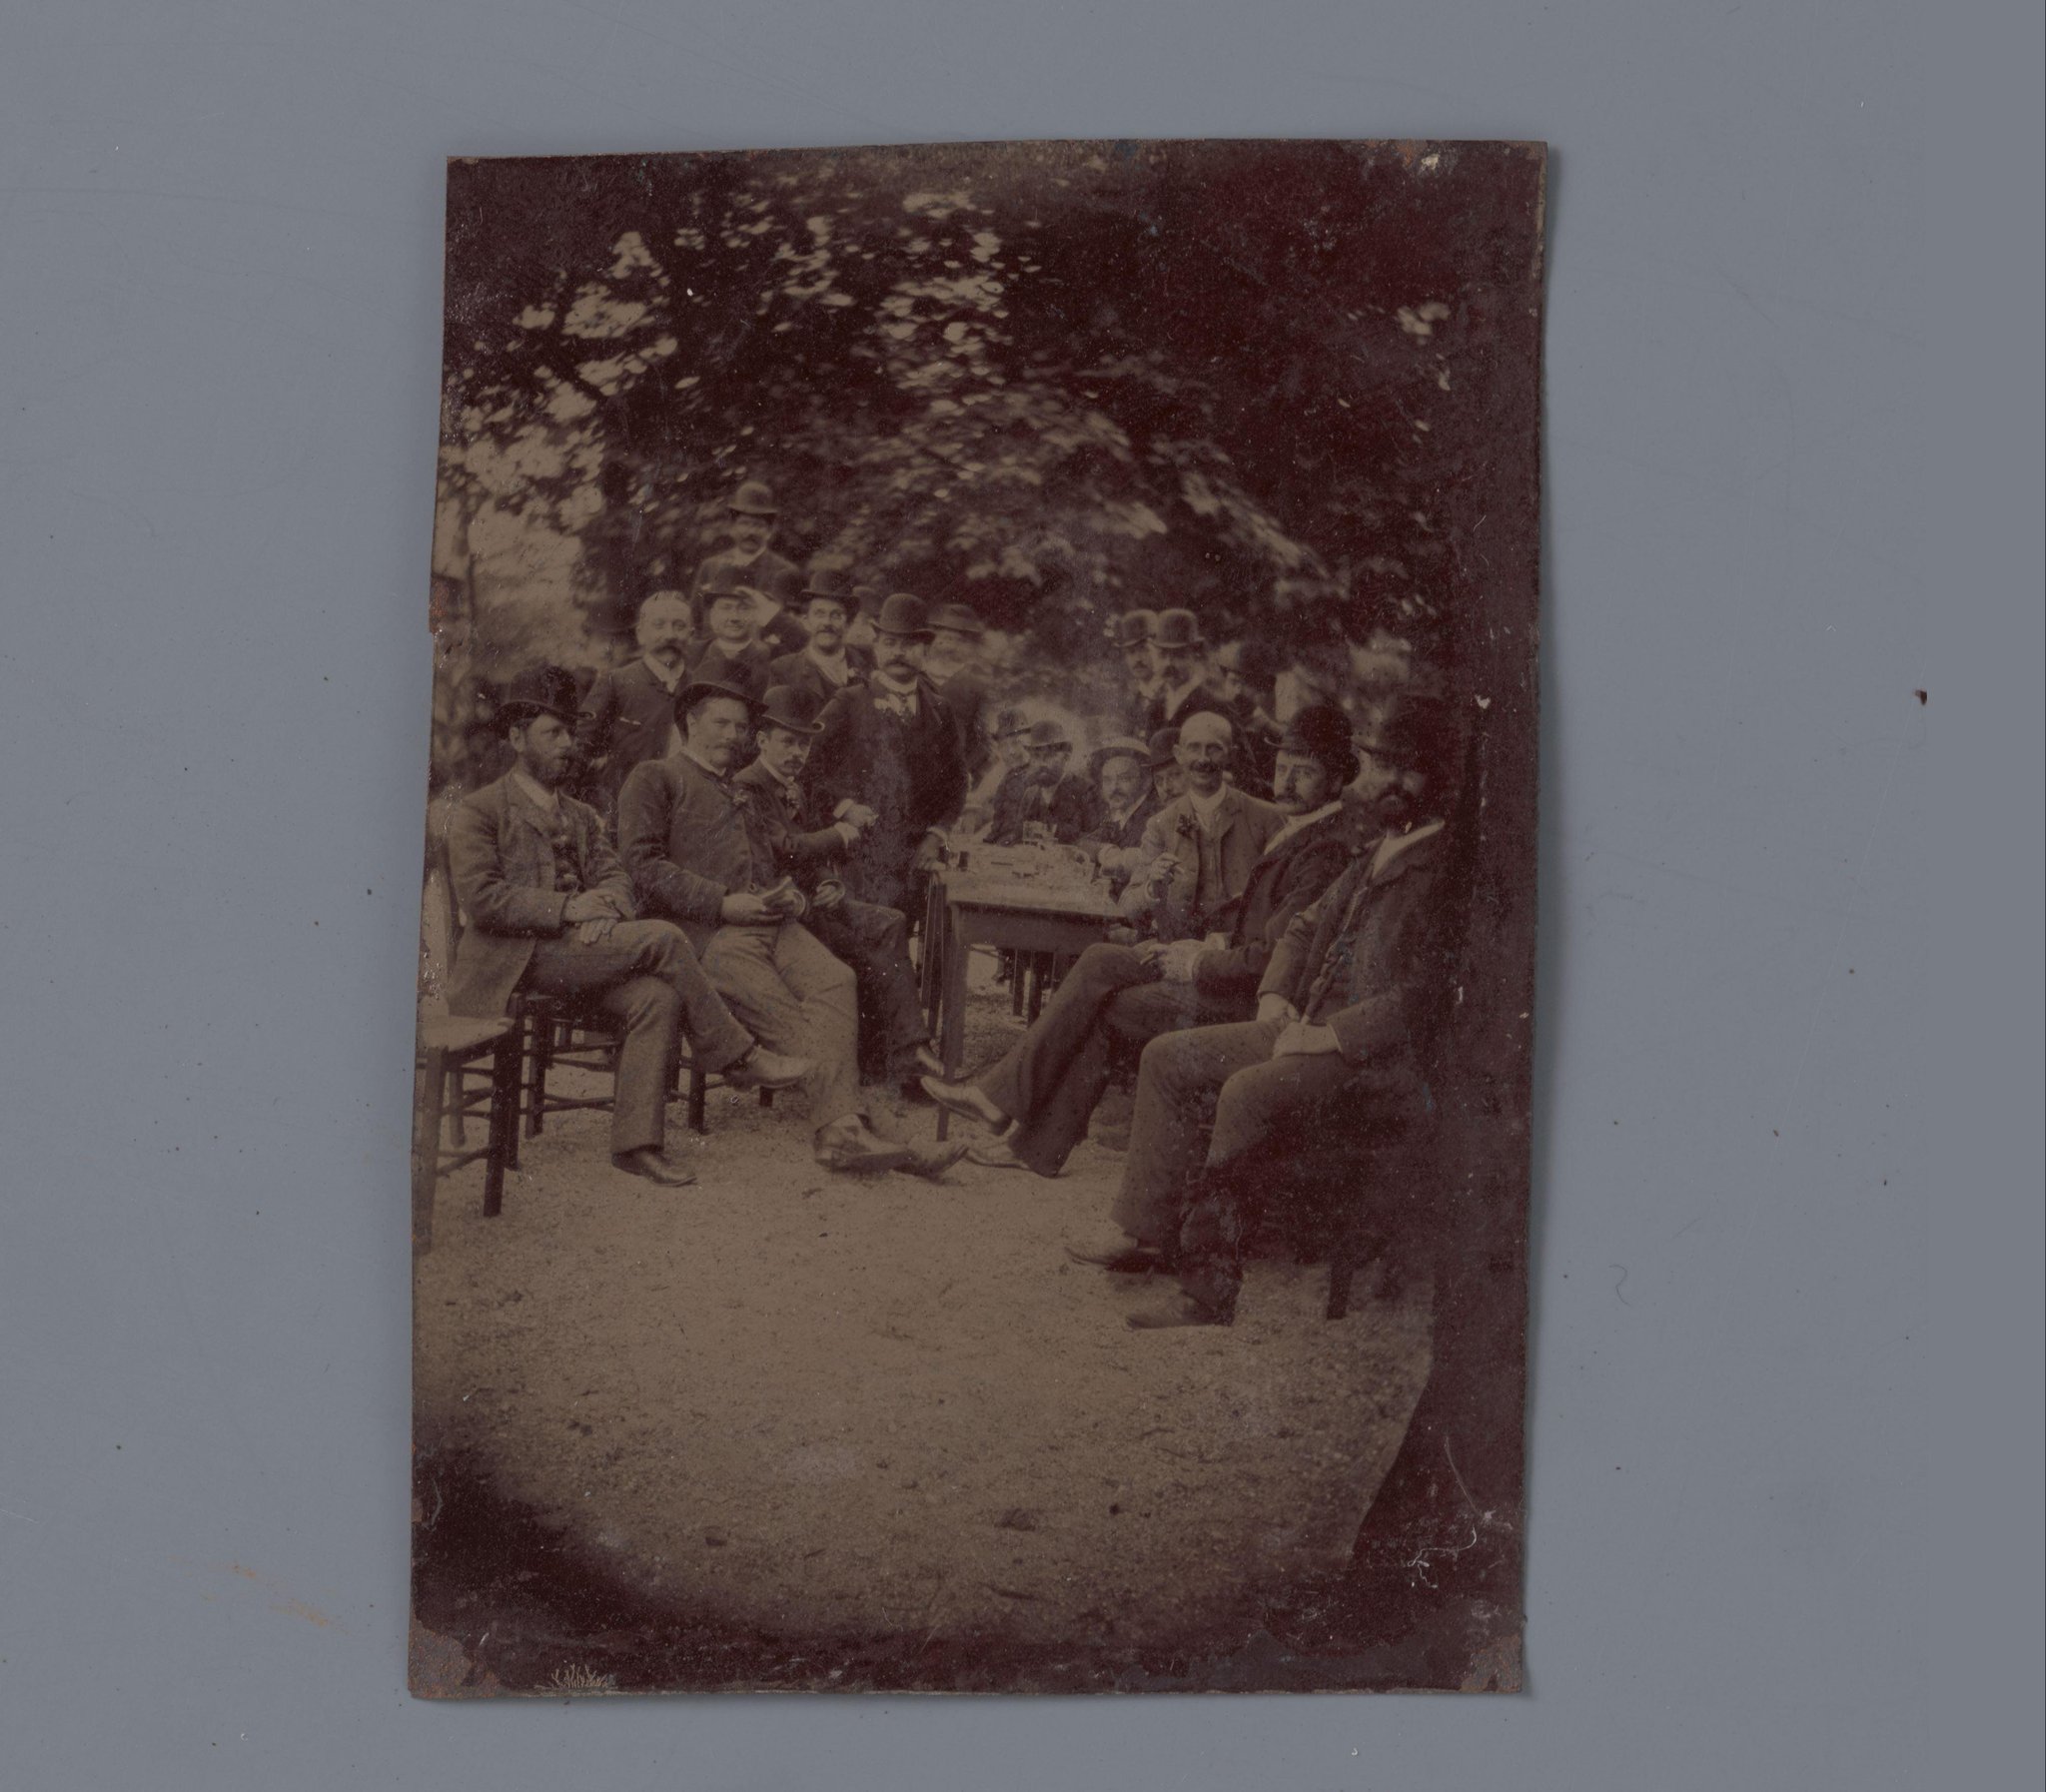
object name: photograph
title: Groepsportret van onbekende mannen rond een tafel in een tuin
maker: Anonymous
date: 1855-1940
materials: iron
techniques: ferrotyping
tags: adult man (+ more than eight persons), anonymous historical persons portrayed in a group, in a group-portrait